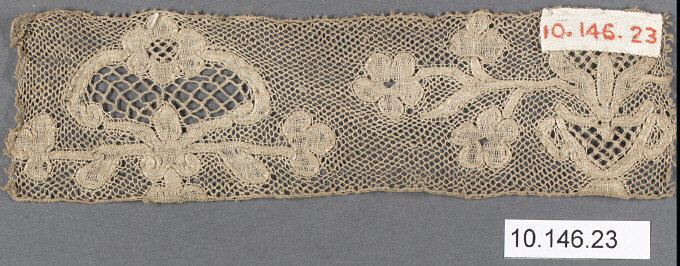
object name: fragment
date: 1701-1800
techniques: lace